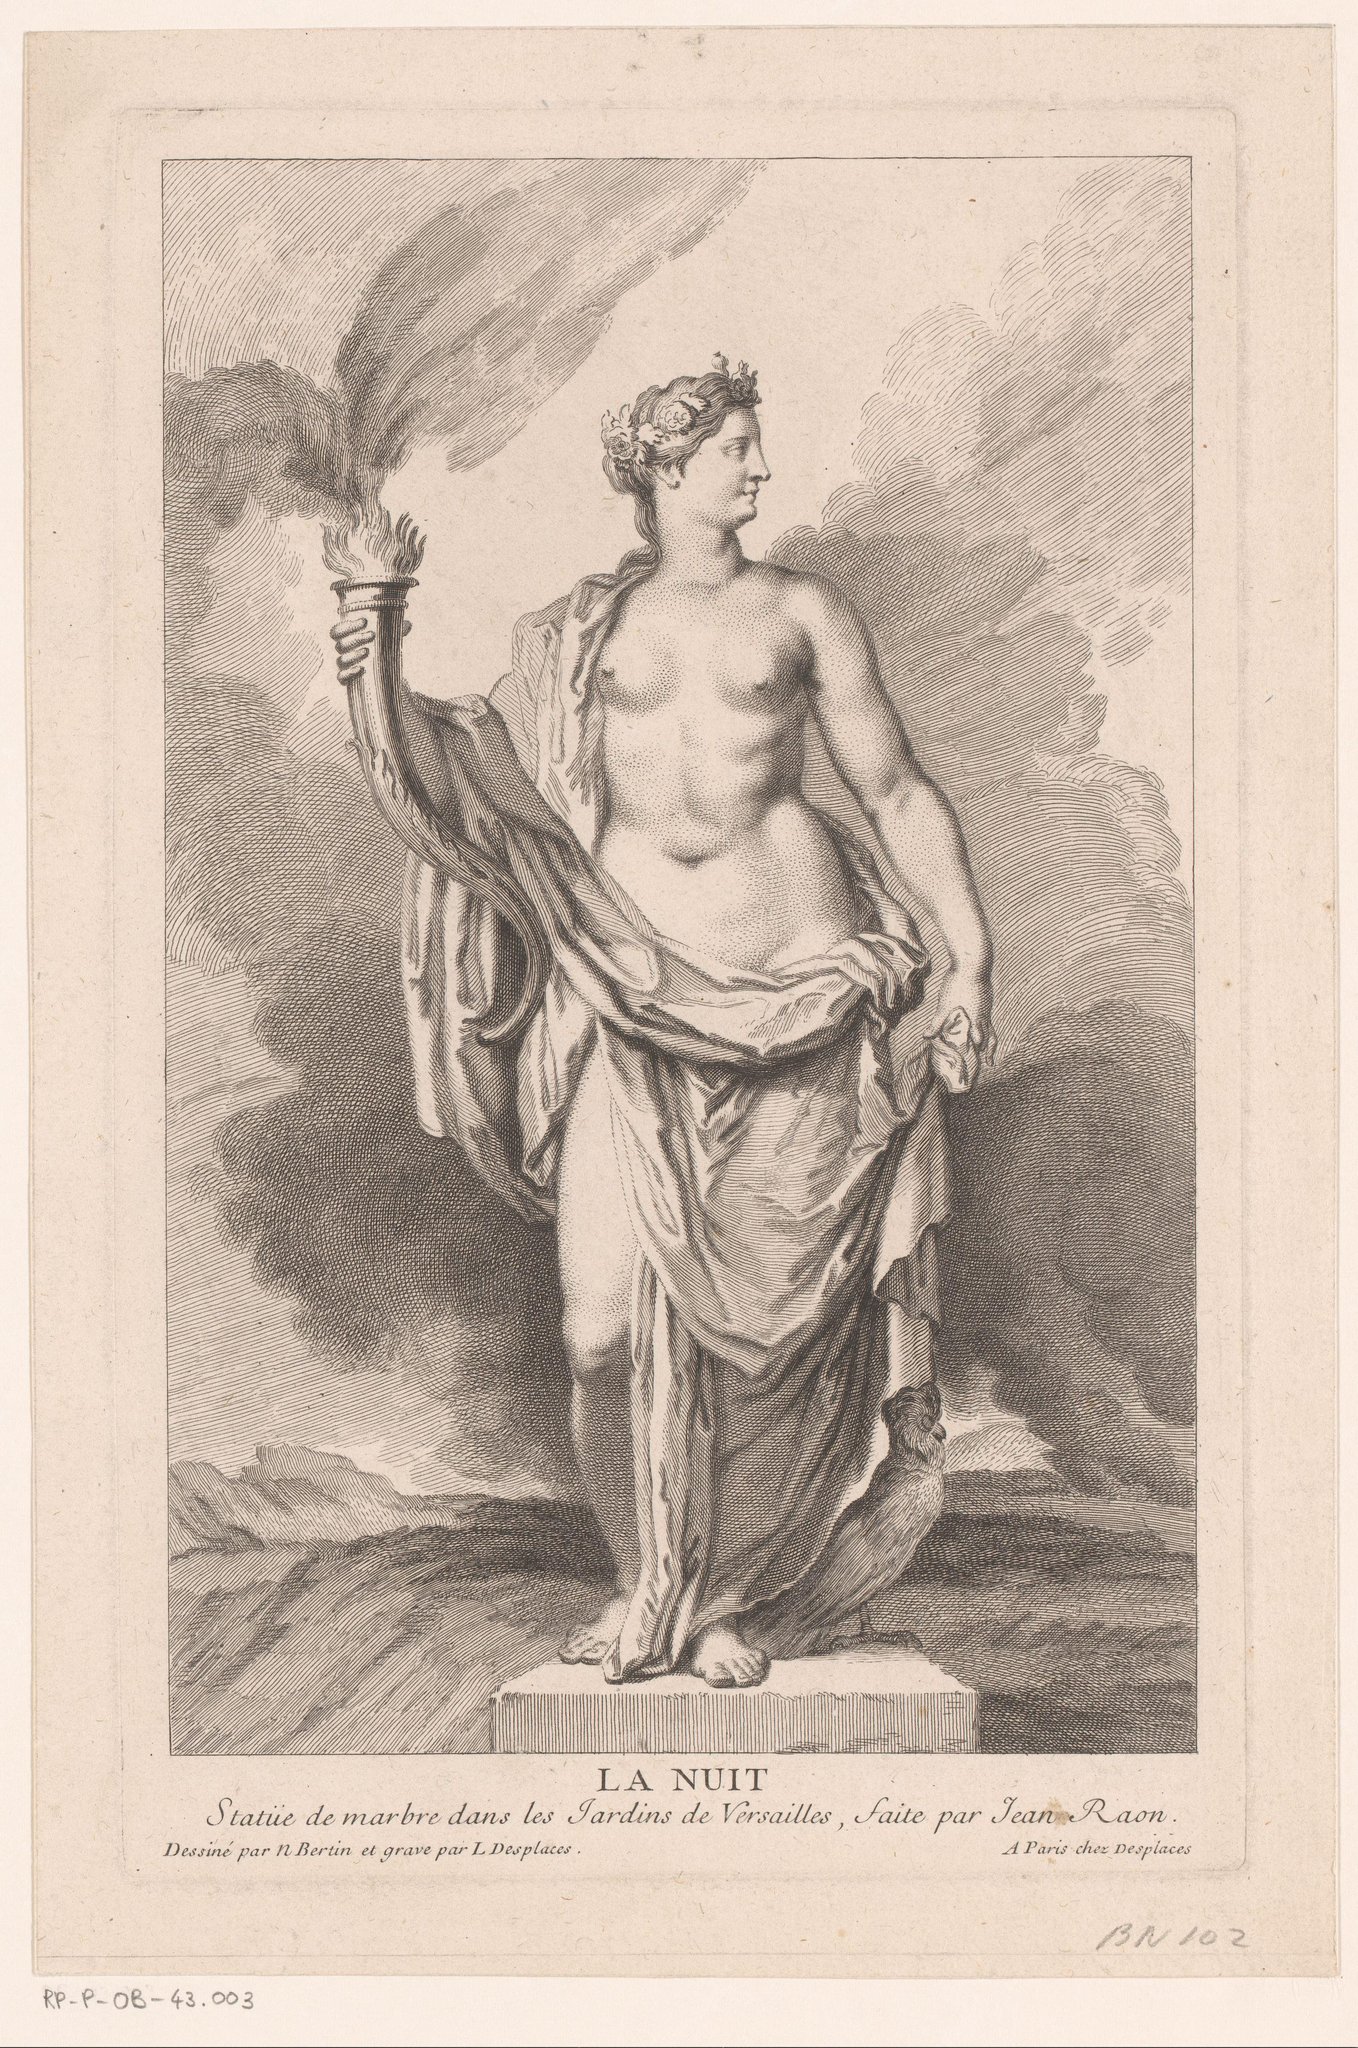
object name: print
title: Nacht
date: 1692-1739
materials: paper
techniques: engraving, etching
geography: paris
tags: personification of the night, 'nox'; 'notte', 'carro della notte', 'serenità della notte' (ripa), piece of sculpture, reproduction of a piece of sculpture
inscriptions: collector's mark: Lugt 240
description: Maakt deel uit van een vierdelige serie naar beelden van de vier dagdelen.